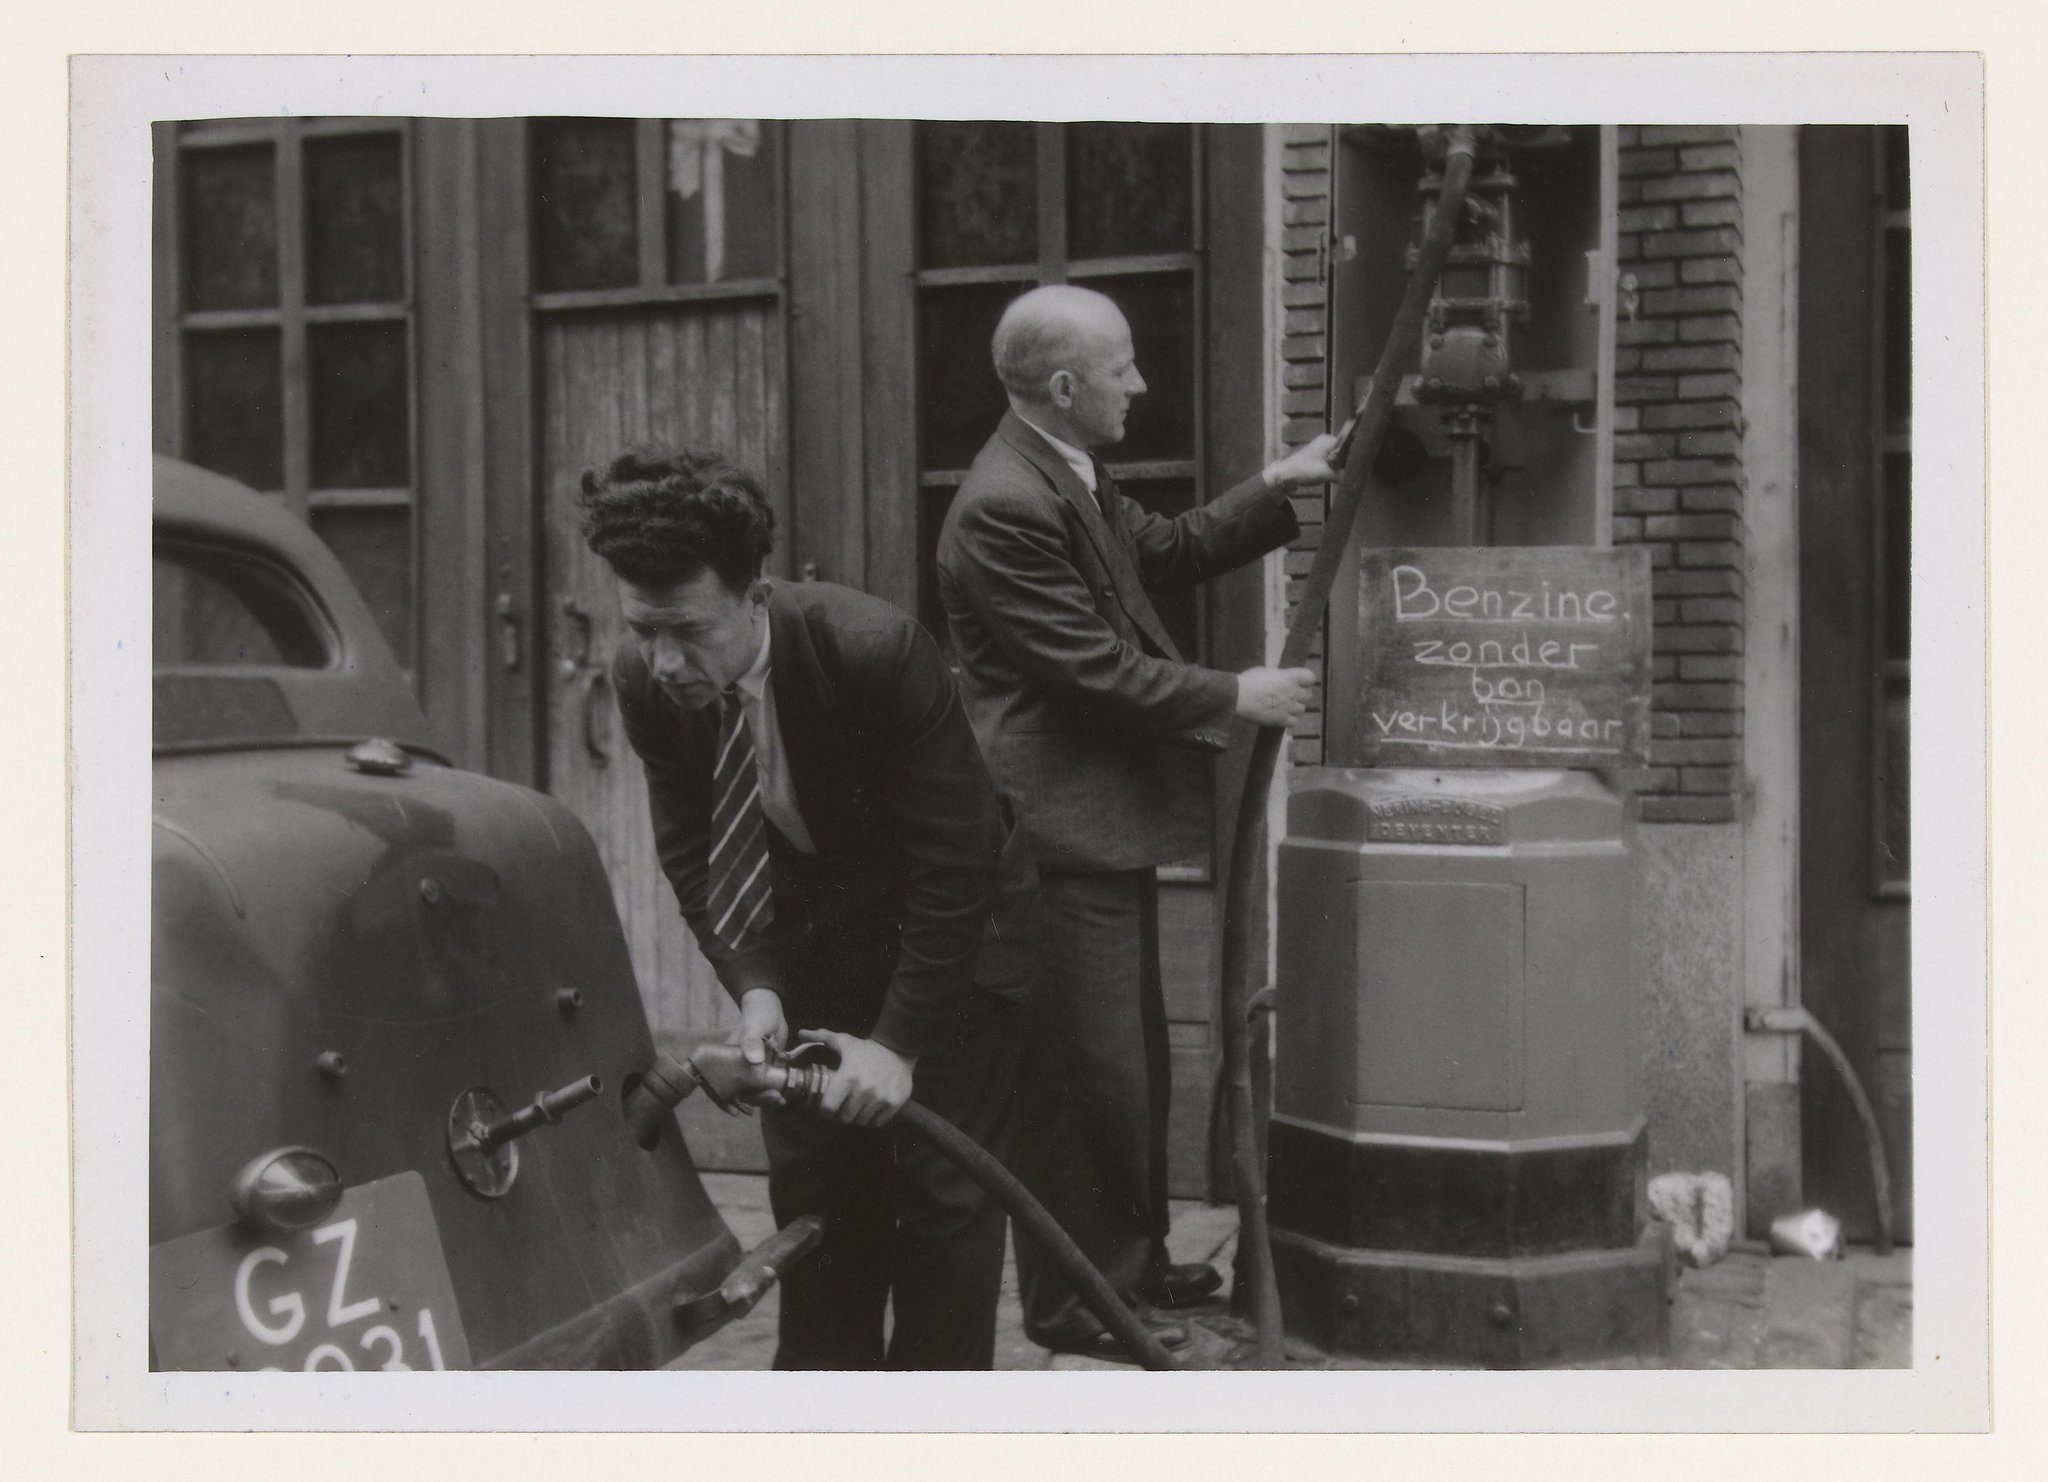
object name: documentary photograph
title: Benzine zonder bon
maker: charles breijer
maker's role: fotograaf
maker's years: 1914-2011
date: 1946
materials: photographic support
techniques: photography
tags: ons vrije nederland, tweede wereldoorlog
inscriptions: number: ‘17783’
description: Twee mannen in pak tanken benzine bij een kleine benzinepomp. Een man met een kaal hoofd houdt de slang vast en de andere man vult de tank van een auto. Volgens het bijschrift is dit een glorieuze dag omdat vanaf 1 juni 1946 benzine weer vrij verkocht mag worden zonder bon.